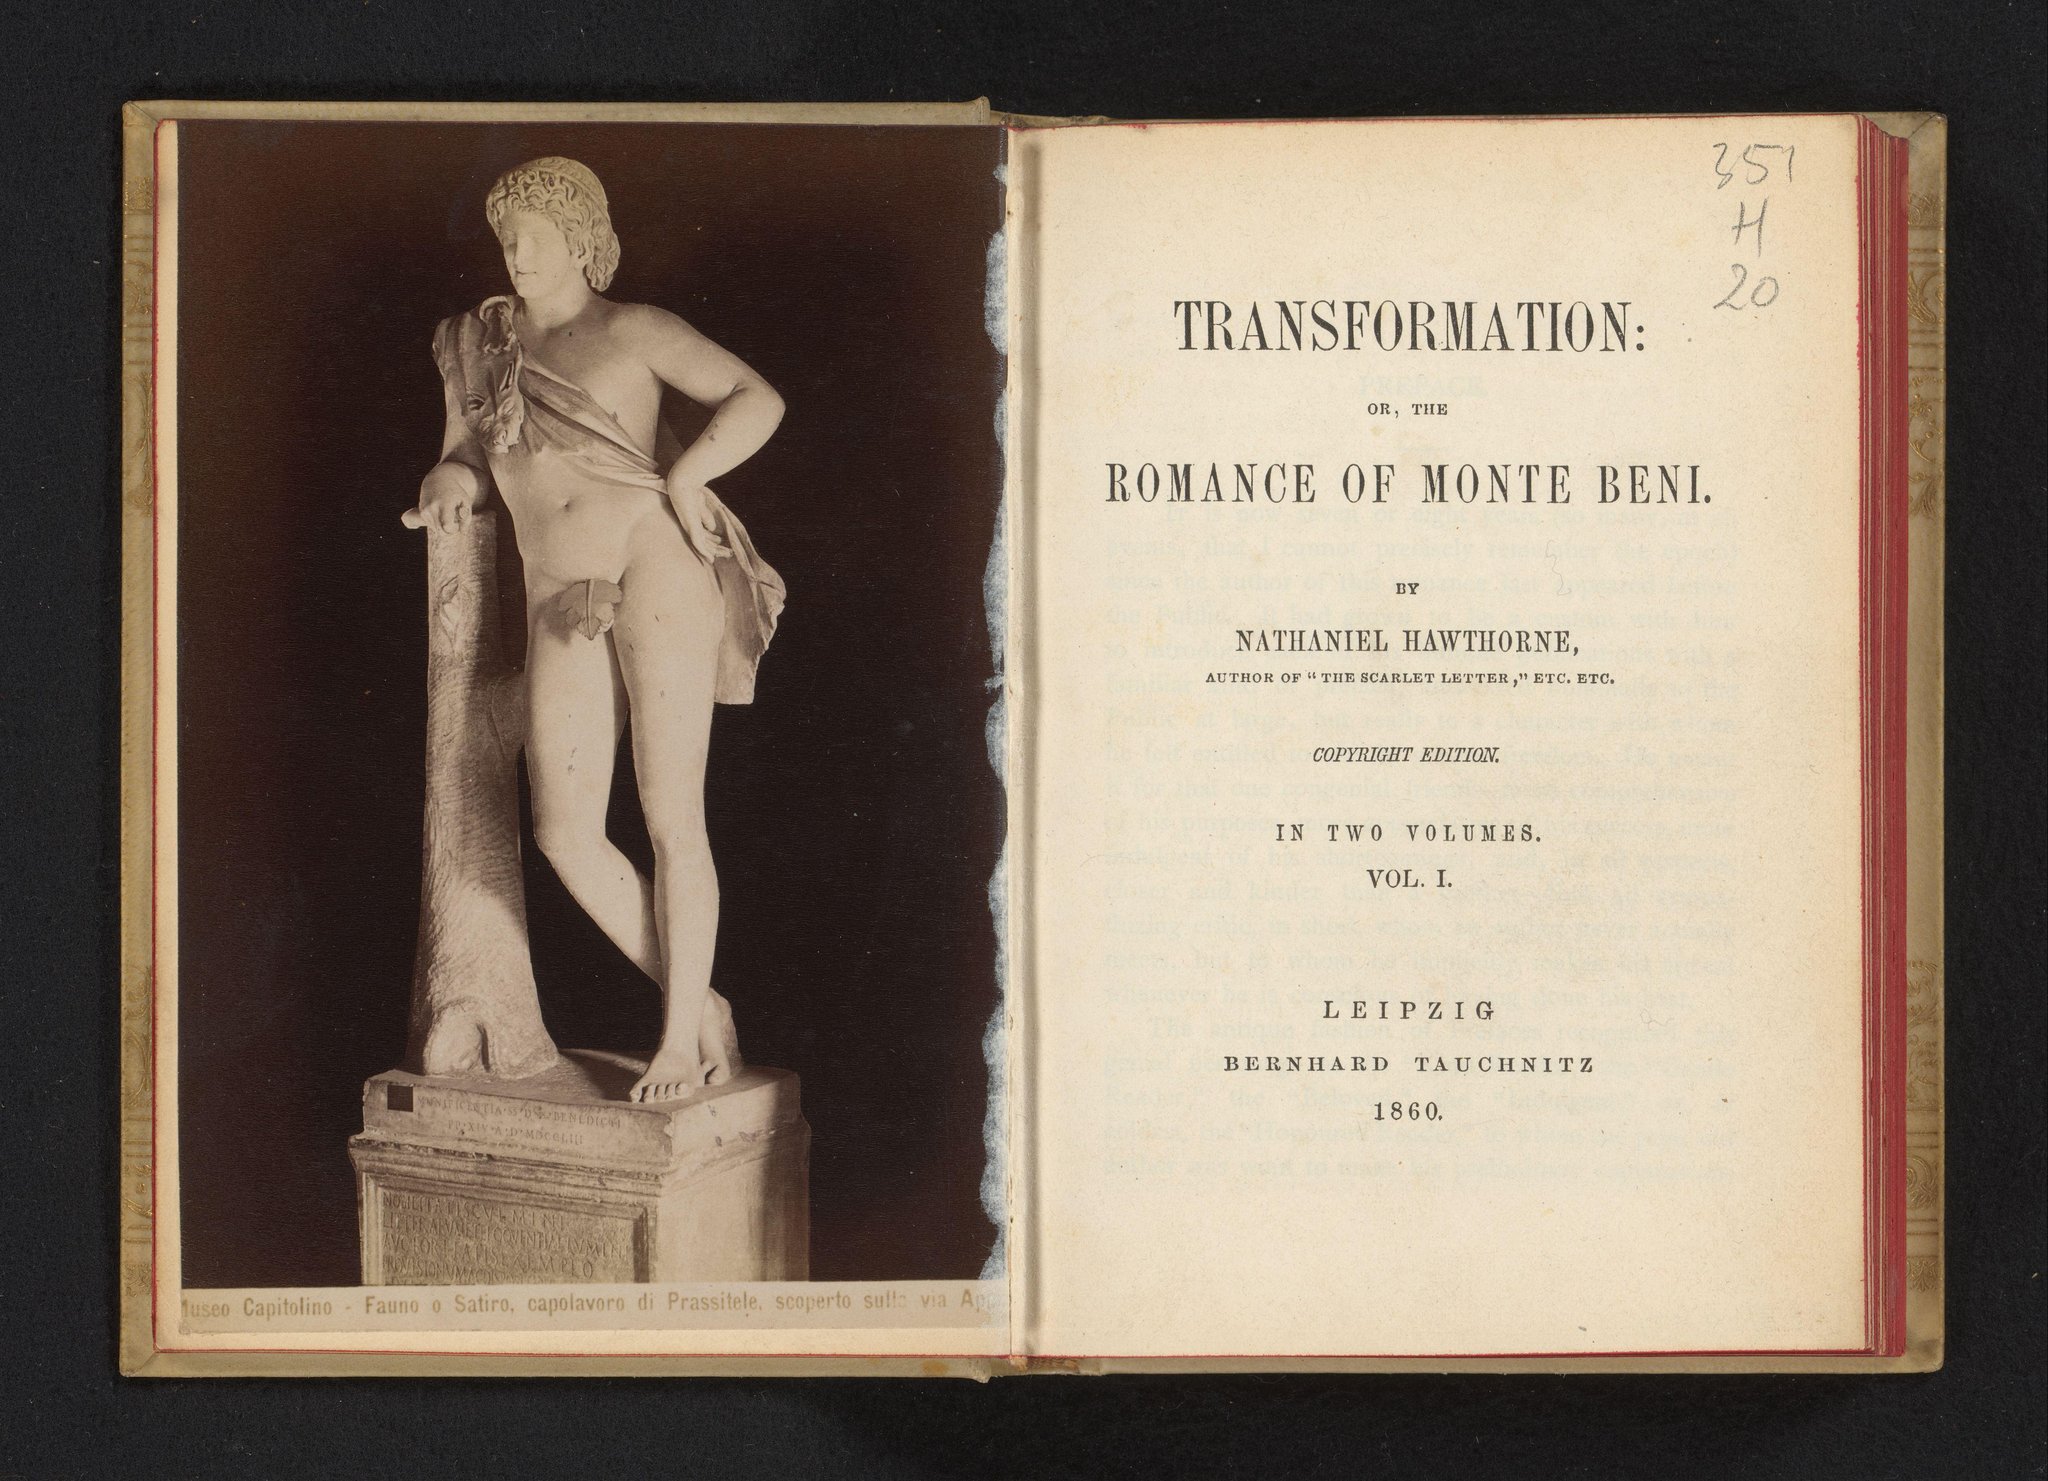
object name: photograph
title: Rustende satyr door Praxiteles in de Capitolijnse Musea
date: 1855-1860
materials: paper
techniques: albumen print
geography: capitolijnse musea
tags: sculpture